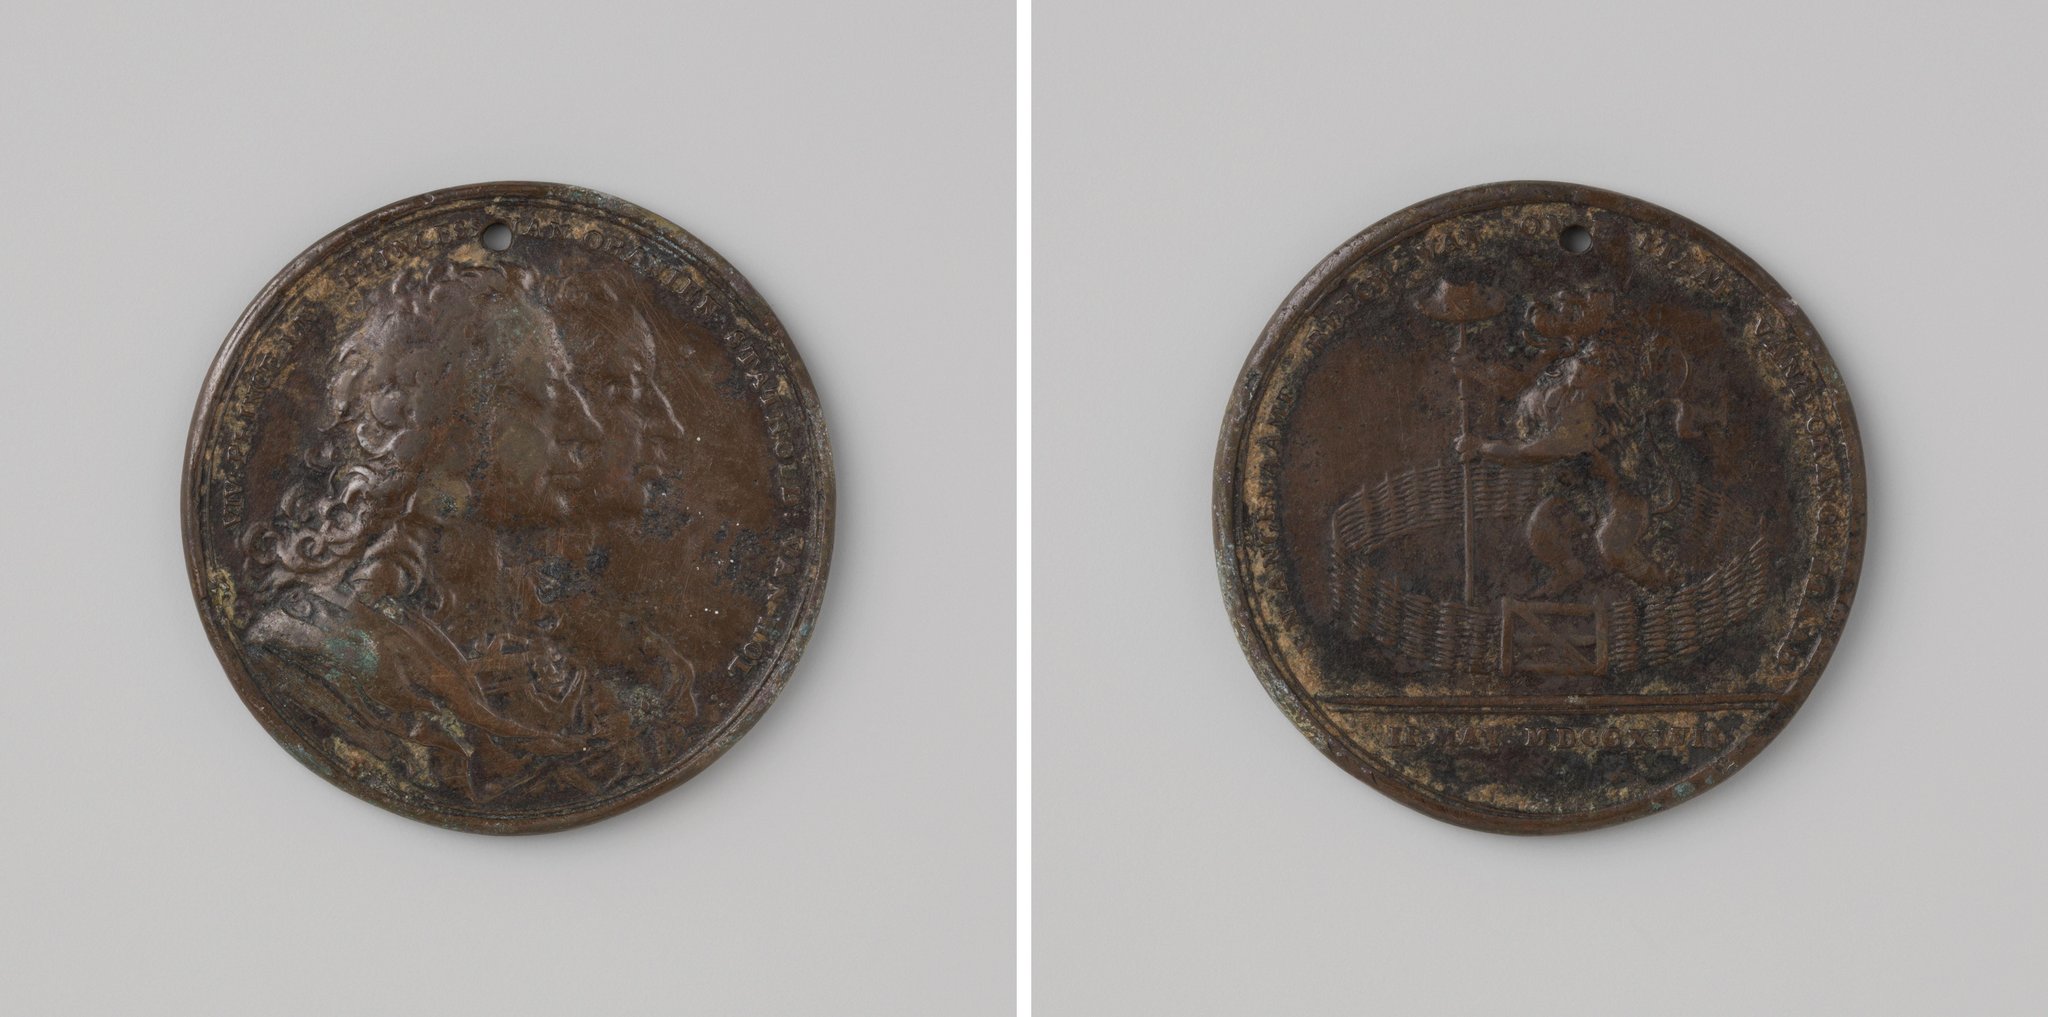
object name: history medal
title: Verheffing van de prins van Oranje tot stadhouder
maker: Anonymous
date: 1747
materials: bronze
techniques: striking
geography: netherlands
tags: willem iv (prins van oranje-nassau), the hague, anna van hannover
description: Bronzen penning met gat erin. Voorzijde: borststuk man en vrouw binnen omschrift. Keerzijde: leeuw met vrijheidshoed op speer binnen afgesloten tuin binnen omschrift; afsnede: datum